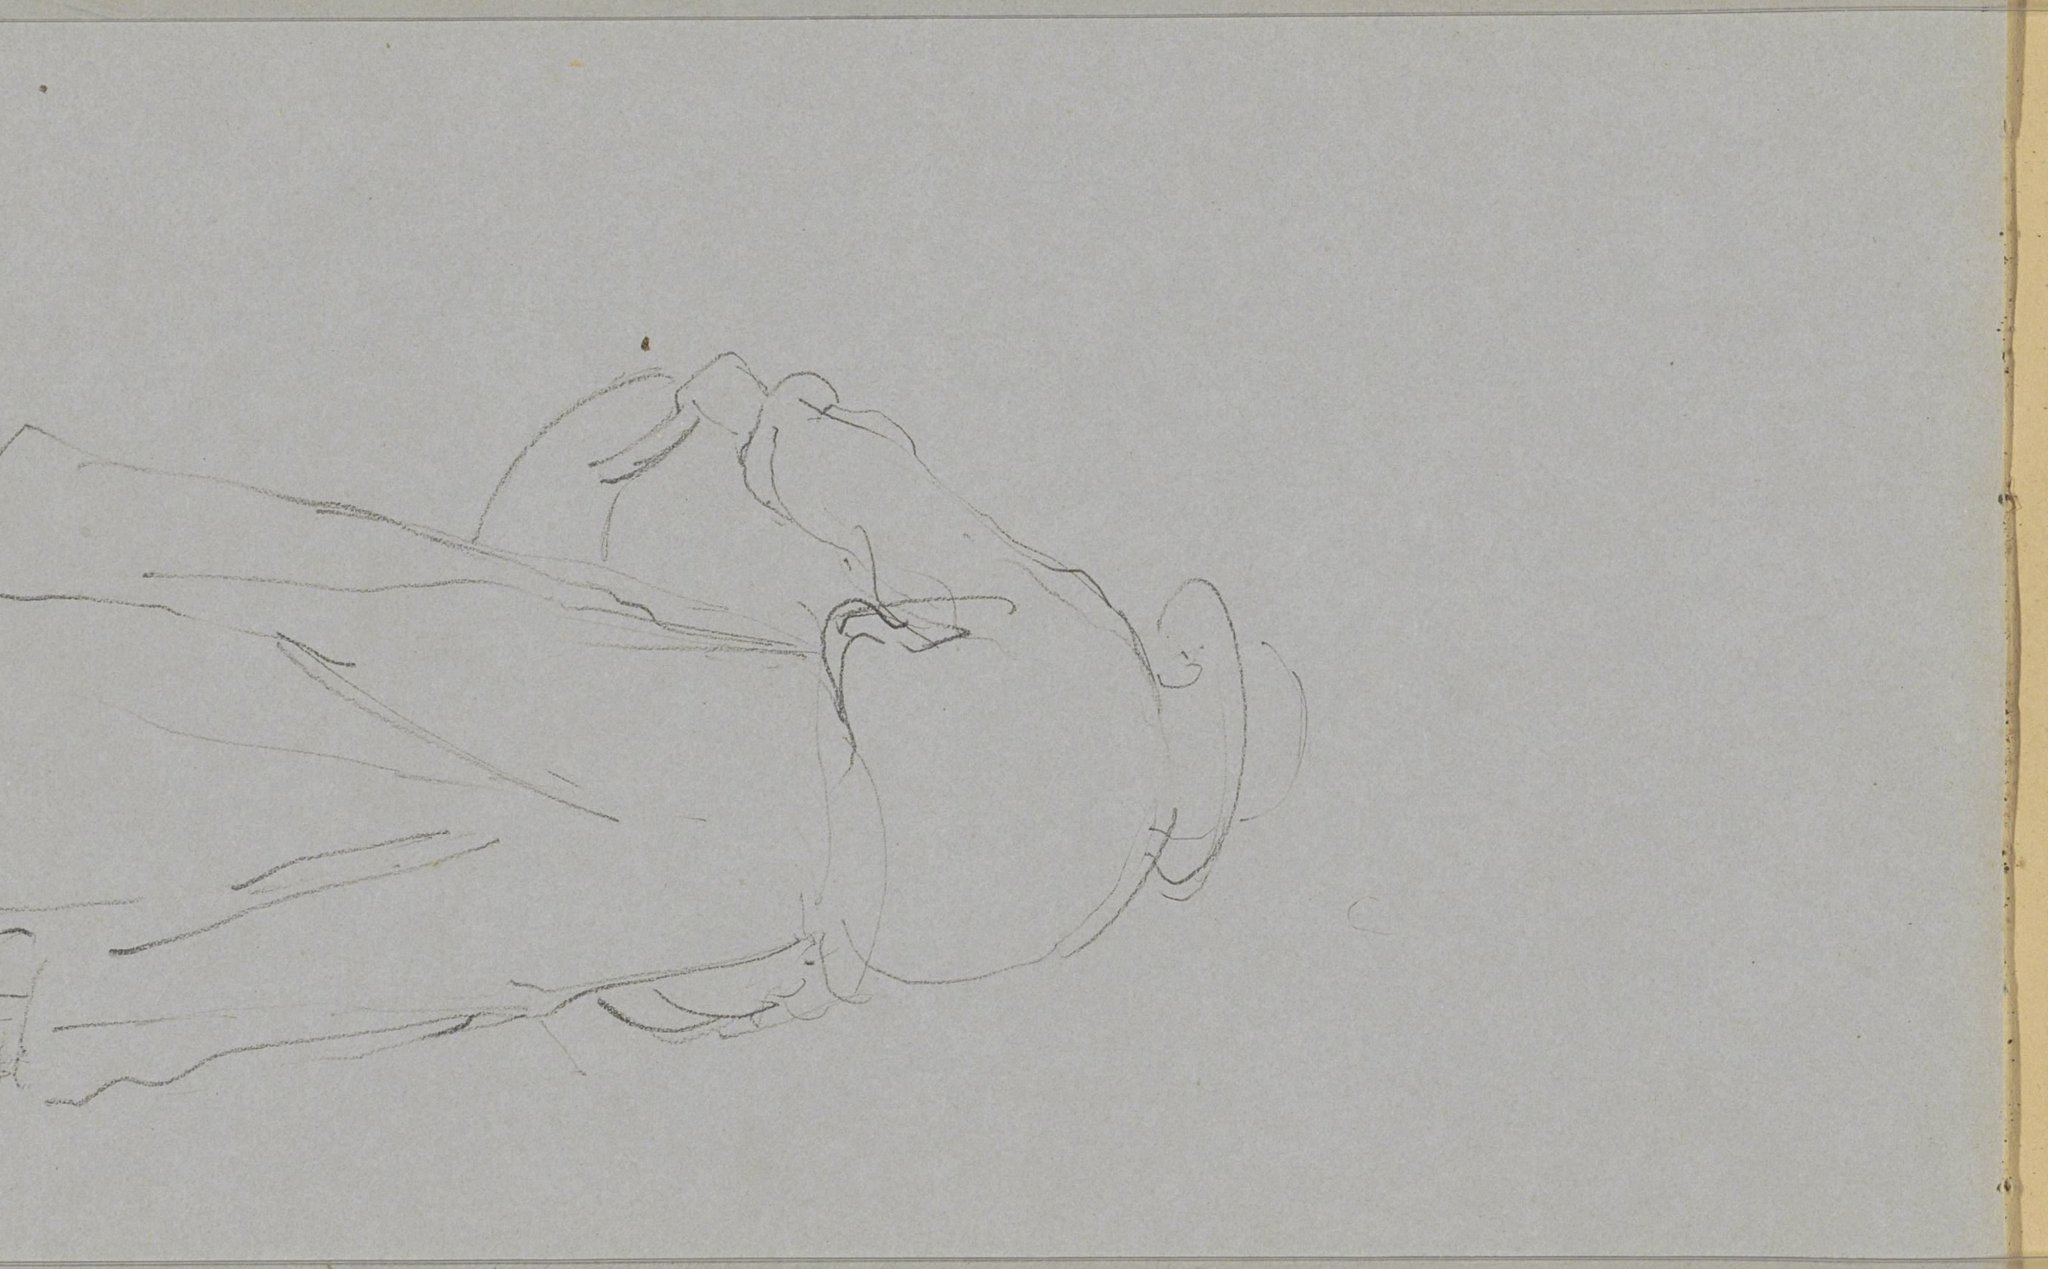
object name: sketchbook leaf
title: Wijdbeens staande man met een hoed, van achteren gezien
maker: a.a.l. de grammont-hubrecht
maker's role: draughtsman, painter, print maker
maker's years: 1855-1913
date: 1865-1913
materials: chalk, paper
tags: standing figure, adult man, head-gear: hat (+ men's clothes)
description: De man heeft een voorwerp in zijn hande. Blad 27 verso uit een schetsboek met 28 bladen.